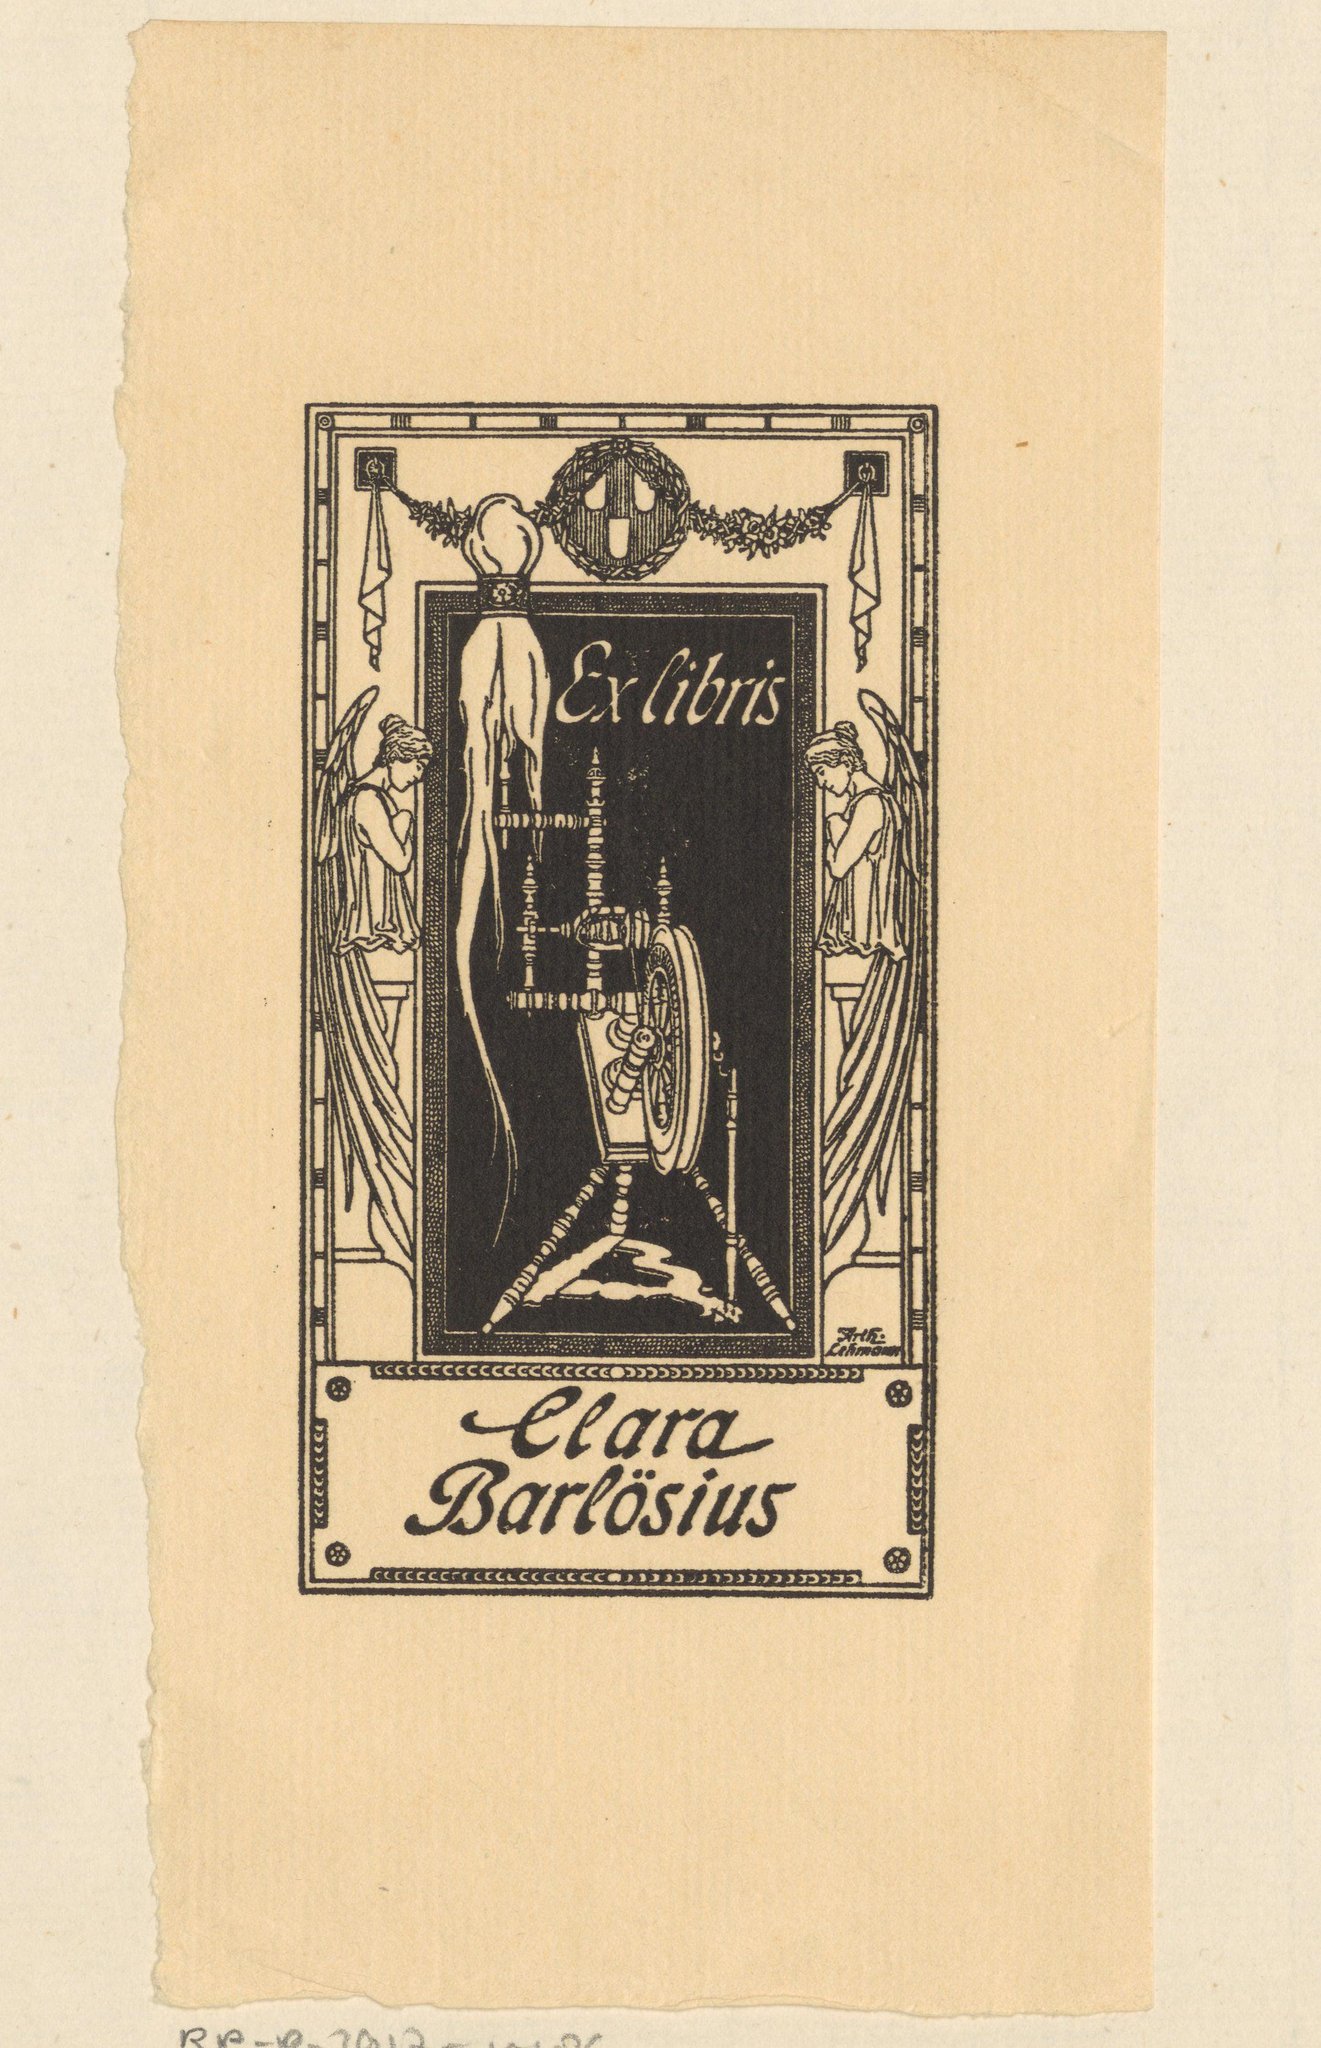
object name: bookplate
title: Ex libris van Clara Barsösius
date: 1870-1949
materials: paper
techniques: printing block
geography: germany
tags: spinning-wheel, angels, armorial bearing, heraldry